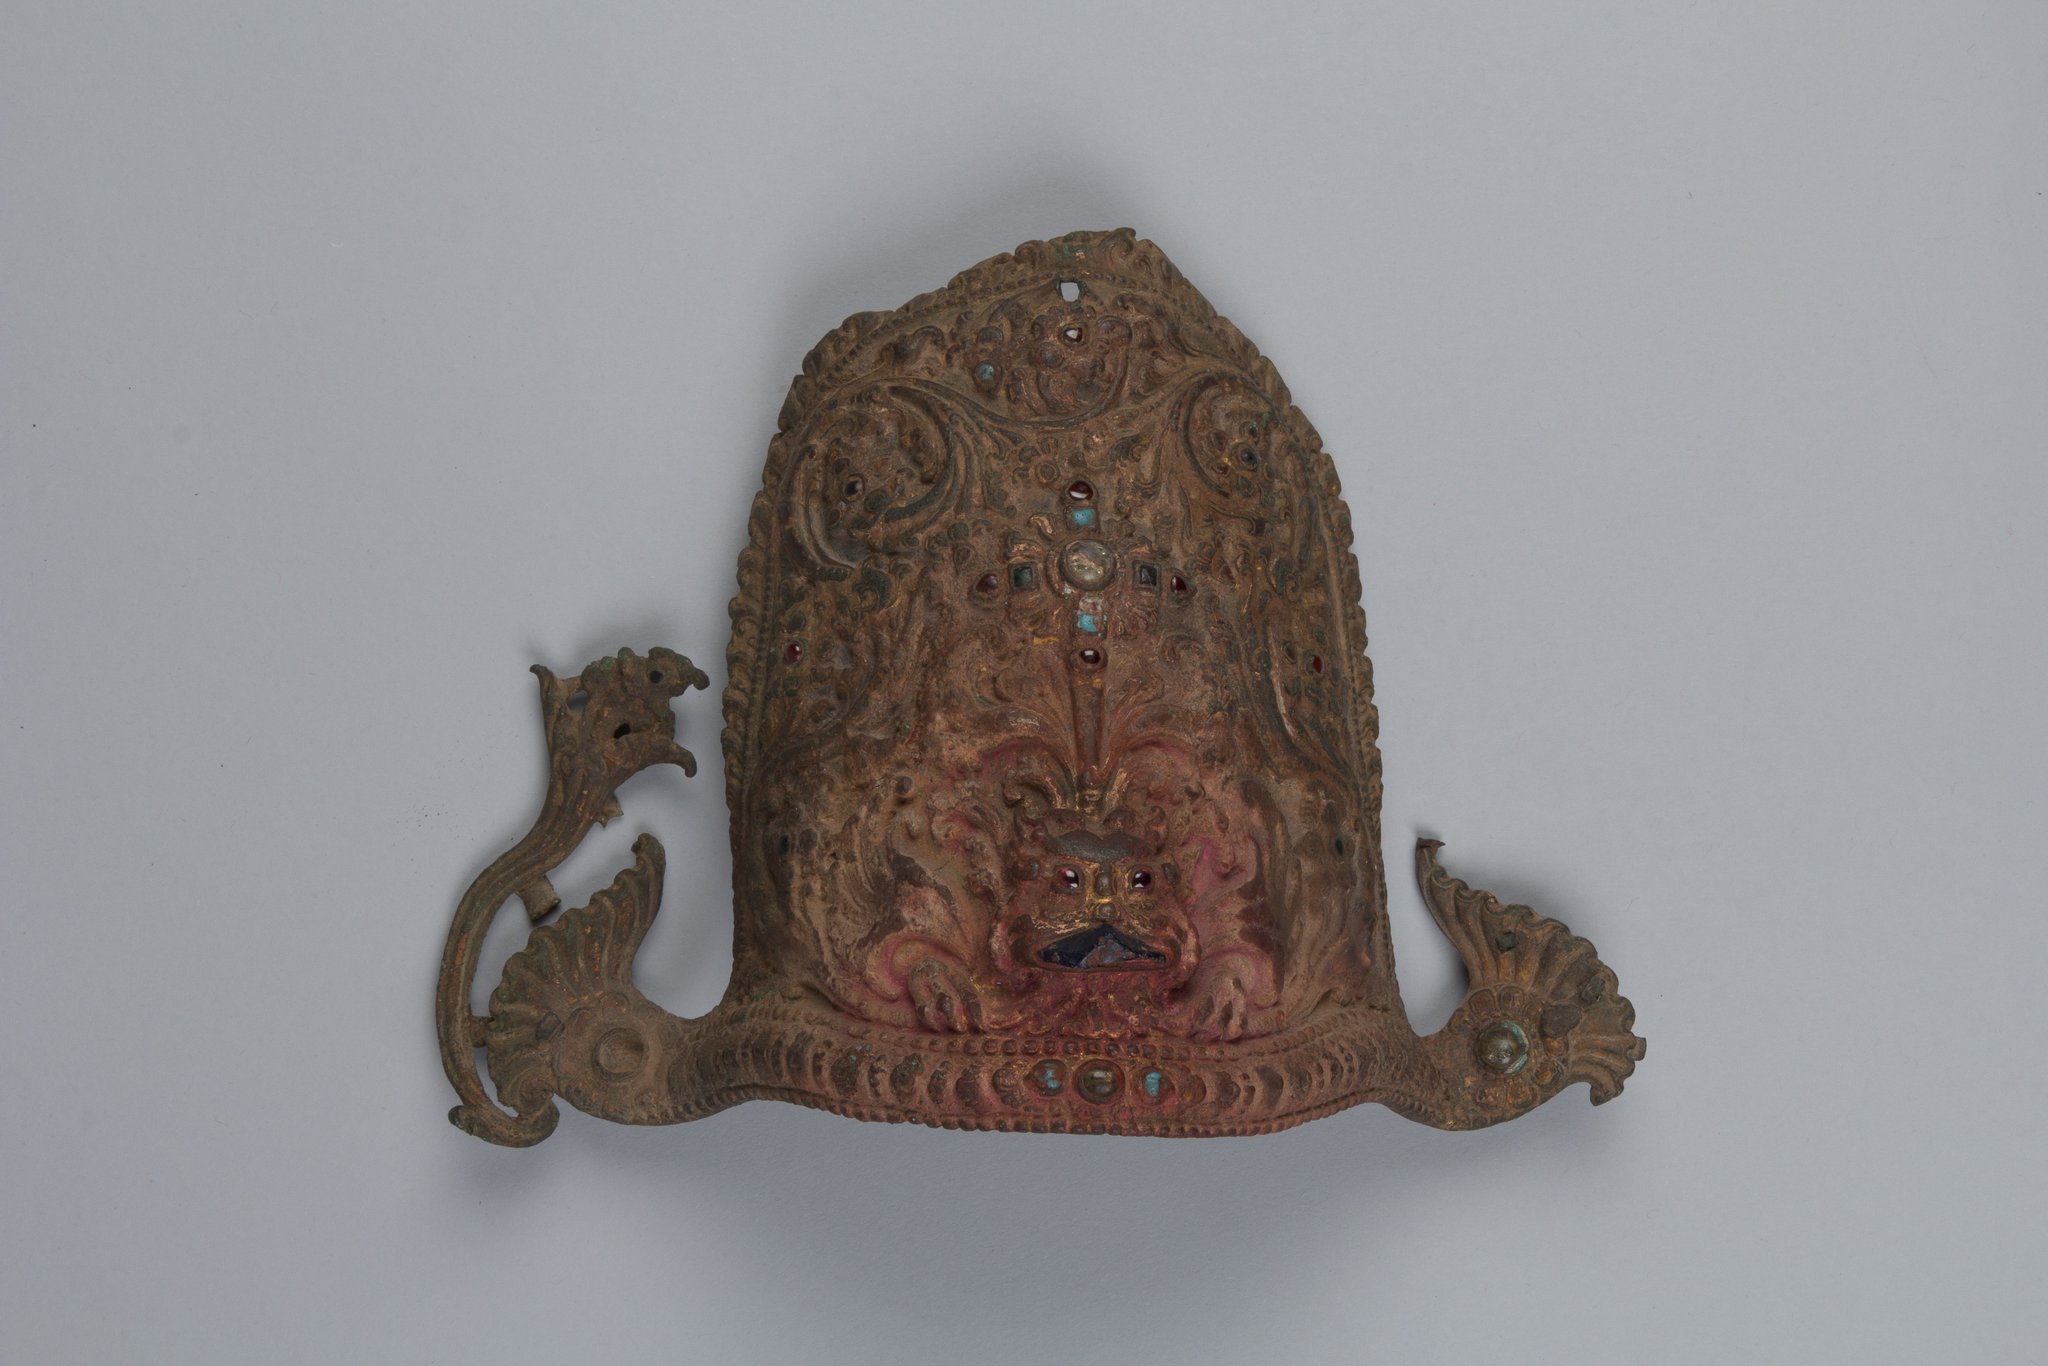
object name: crown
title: Indra's Crown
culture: nepali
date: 1301-1500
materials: copper alloy, glass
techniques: gilding, inlay